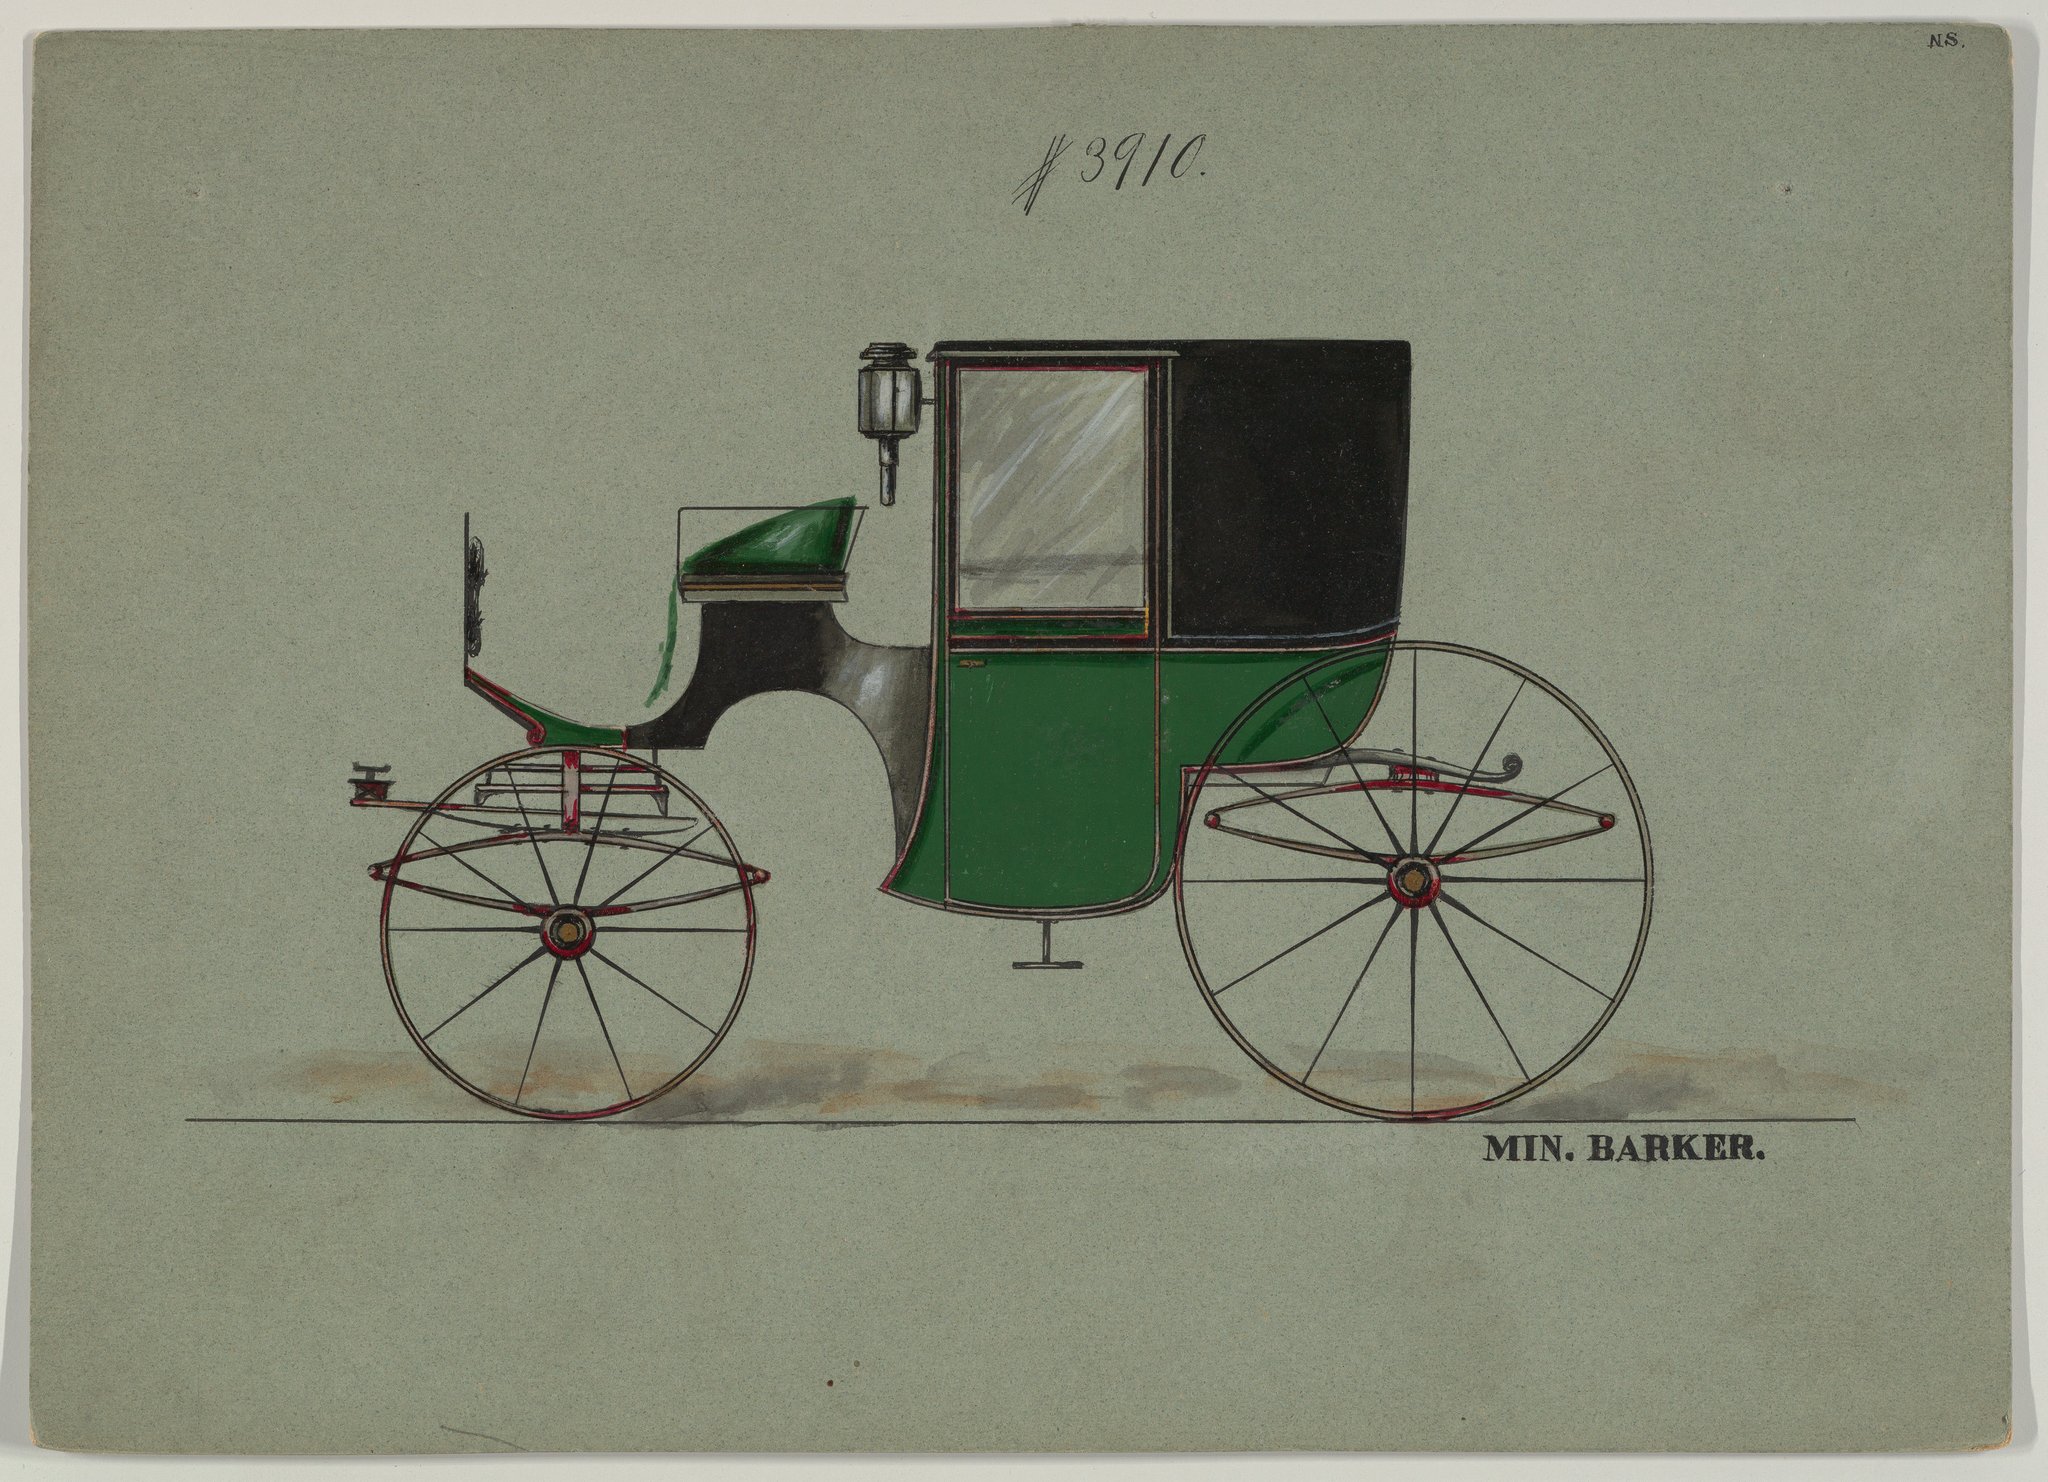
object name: drawing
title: Brougham #3910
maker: brewster & co.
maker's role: manufacturer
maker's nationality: american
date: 1884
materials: gouache, gum arabic, ink, watercolor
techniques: pen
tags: carriages